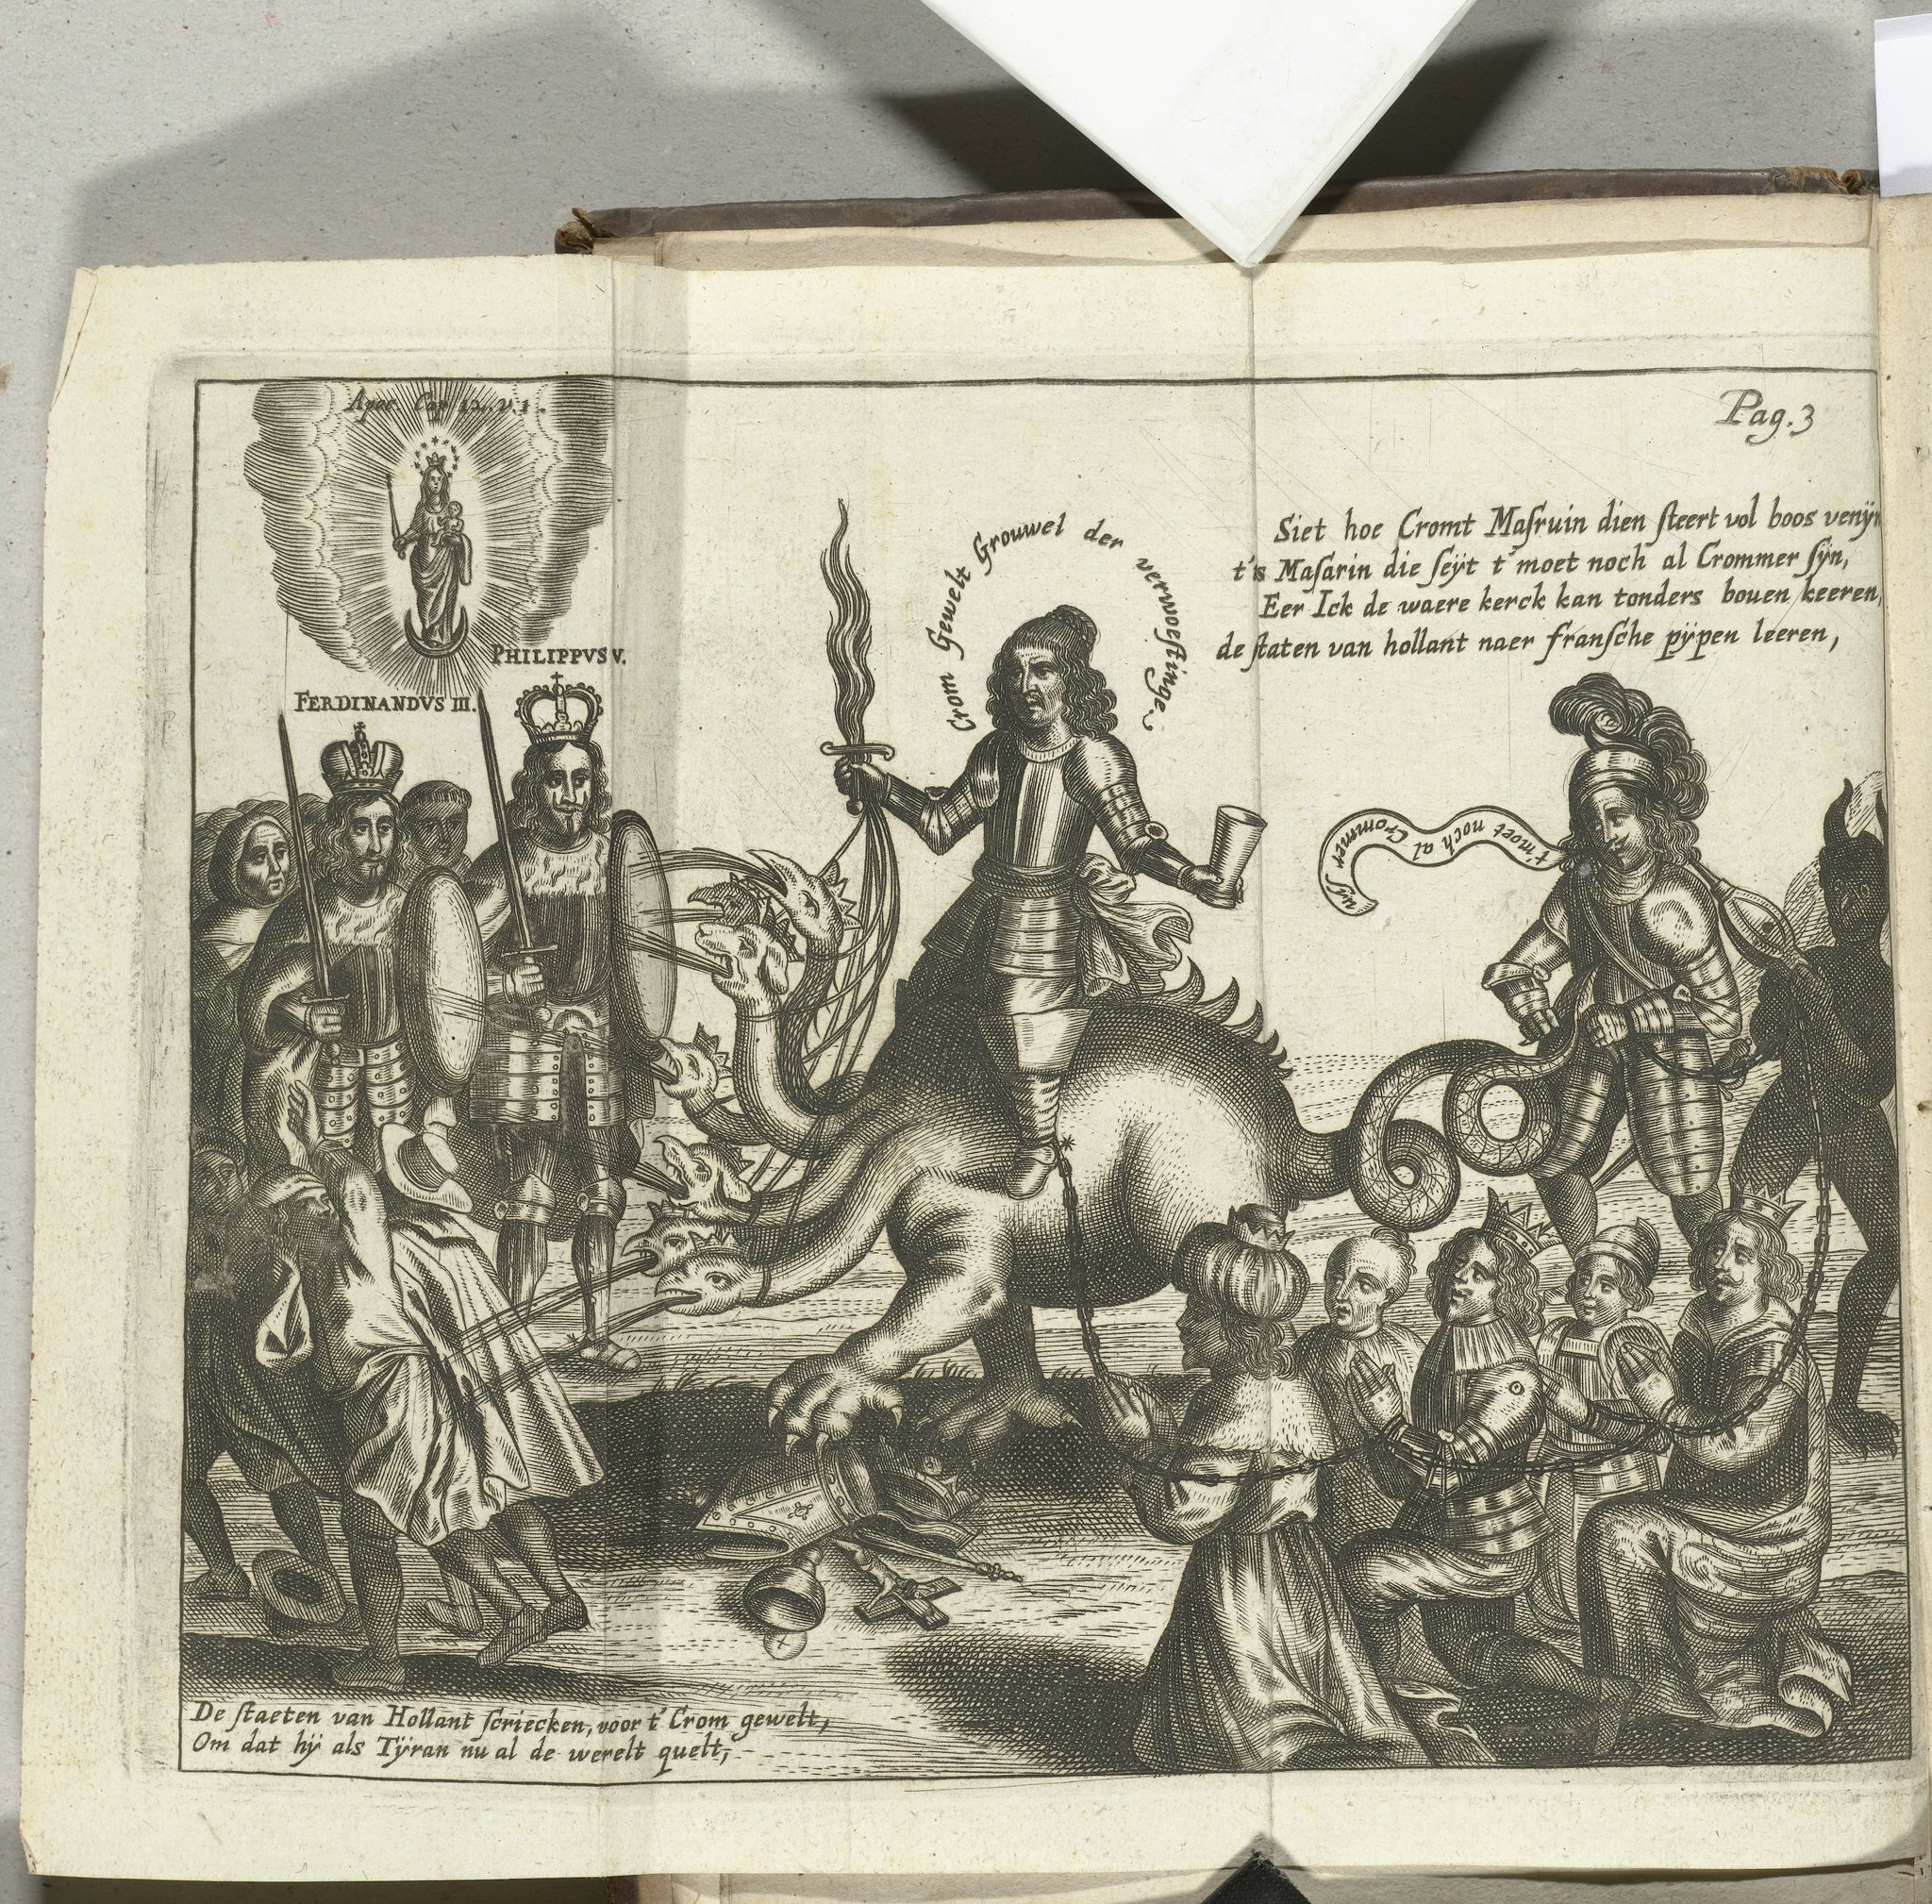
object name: pamphlet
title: Spotprent op Cromwell, 1656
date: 1656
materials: paper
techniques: engraving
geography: cologne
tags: filips iv (koning van spanje), vienna, ferdinand iii (duits keizer), london, oliver cromwell, the scarlet woman, the whore of babylon; she is usually sitting on a scarlet beast with seven heads and ten horns, political caricatures and satires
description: Spotprent op Oliver Cromwell uit 1656. Cromwell als de hoer van Babylon gezeten op de zevenkoppige draak bedreigt de katholieke vorsten Filips IV en Ferdinand III en vertrapt symbolen van de katholieke kerk. Vertegenwoordigers van de Staten van de Verenigde Provincies vluchten voor zijn geweld. Achter de draak de geketende gevangen vorsten van andere landen. Een ridder geketend door de duivel draait aan de staart van de draak. In de voorstelling opschriften in het Nederlands. Gemerkt rechtsboven: Pag. 3.